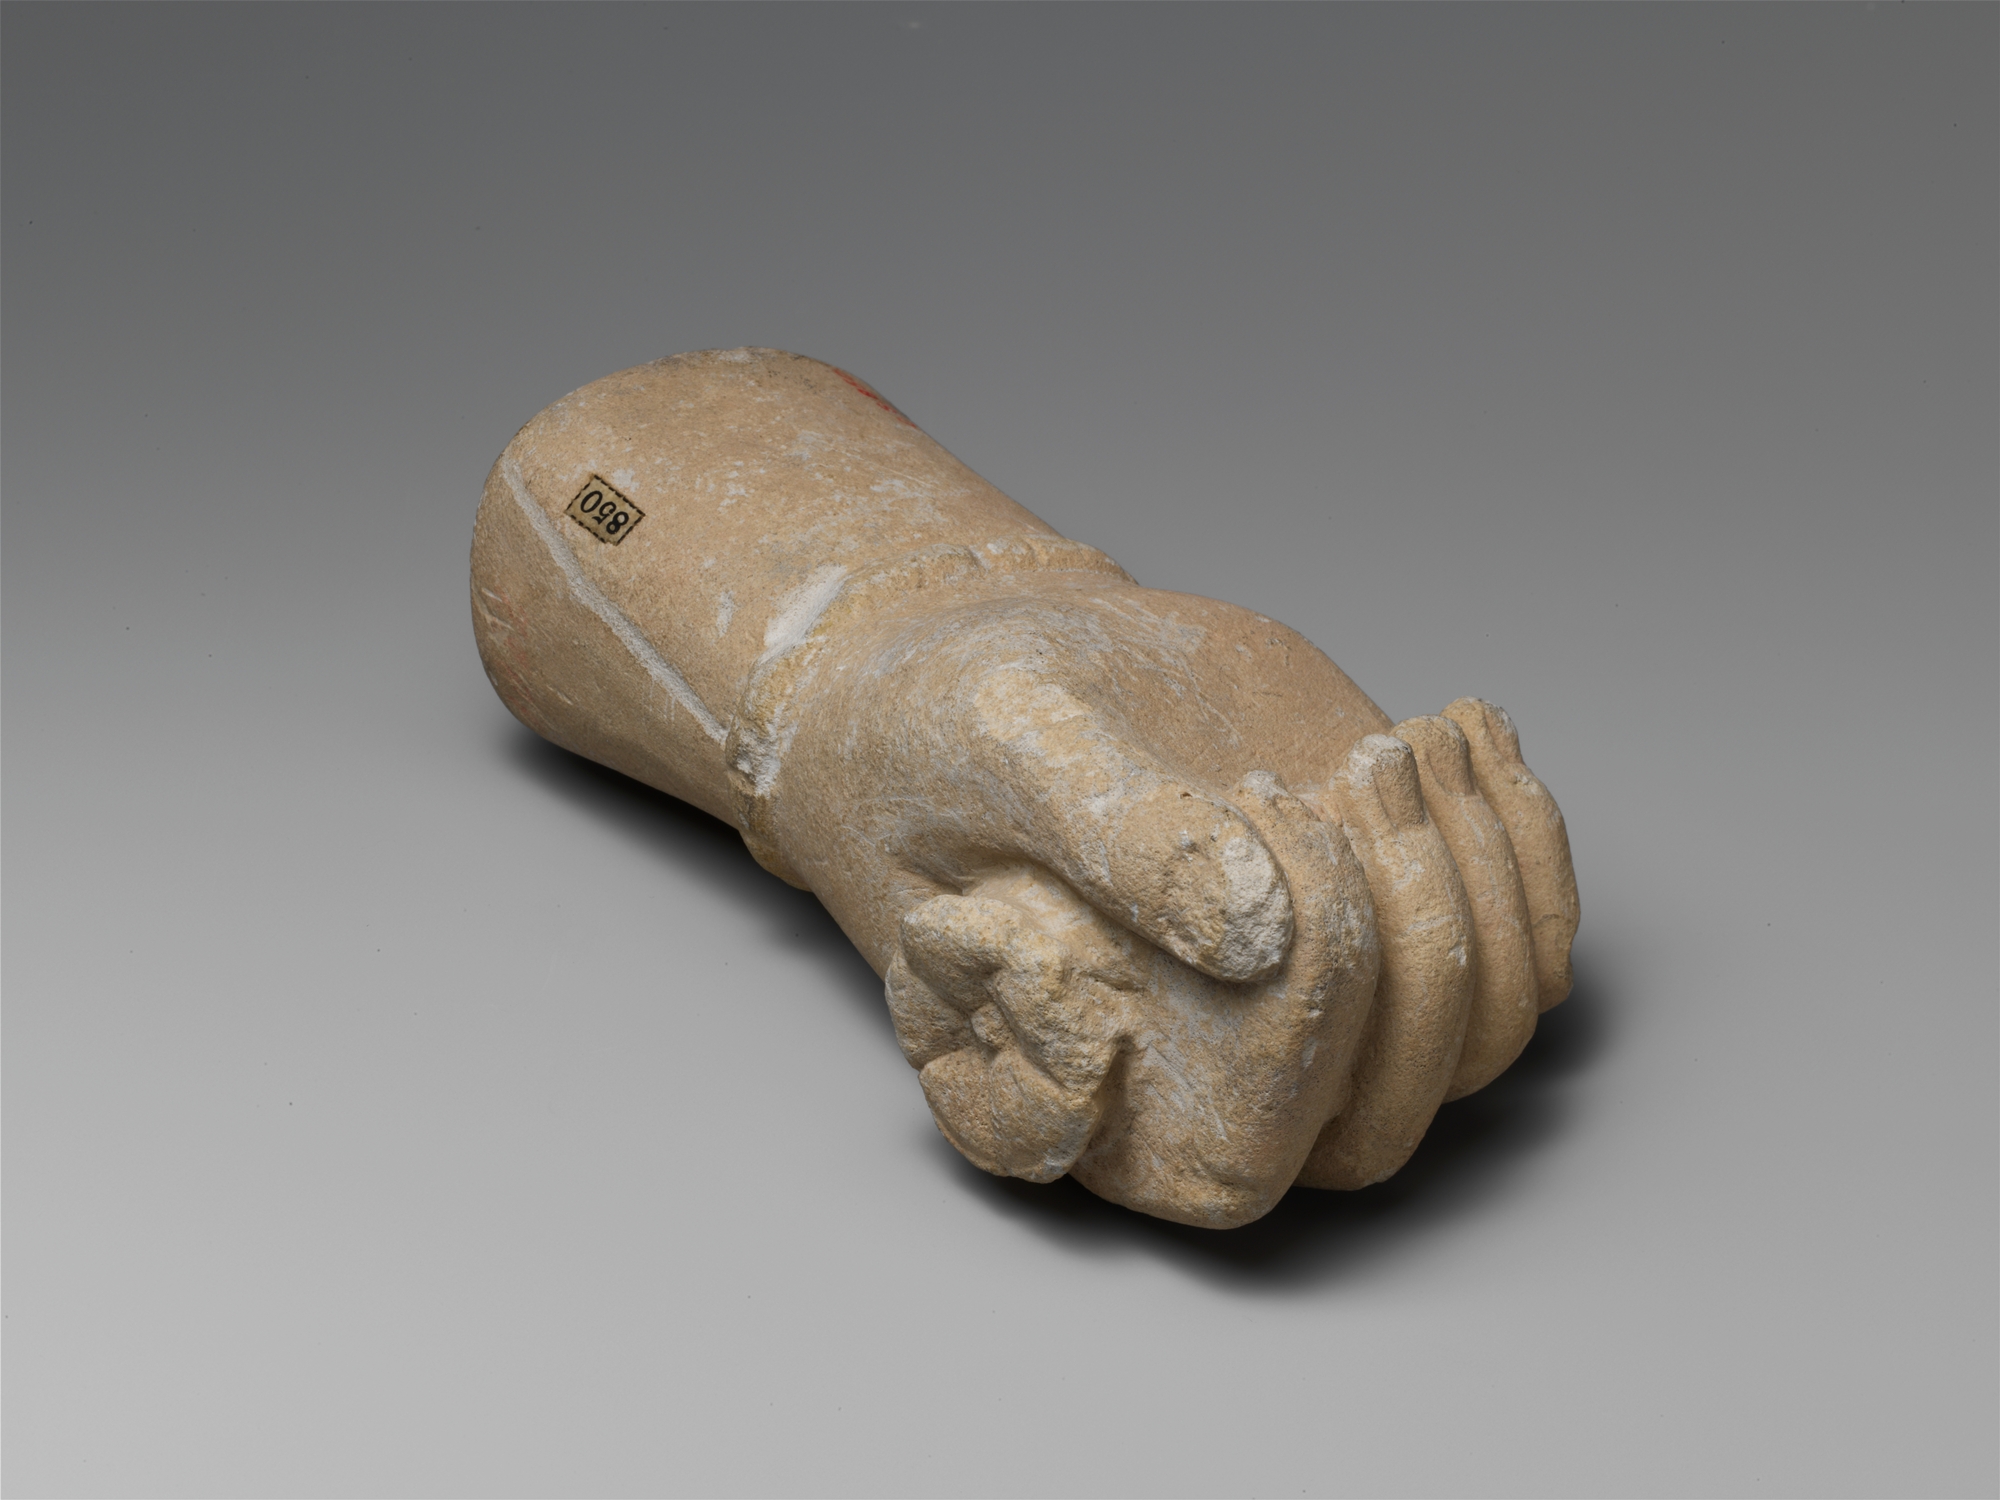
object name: statue fragment of a right hand with a bracelet, holding a flower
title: Limestone statue fragment of a right hand with a bracelet, holding a flower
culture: cypriot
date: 400-201 BCE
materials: limestone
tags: hands